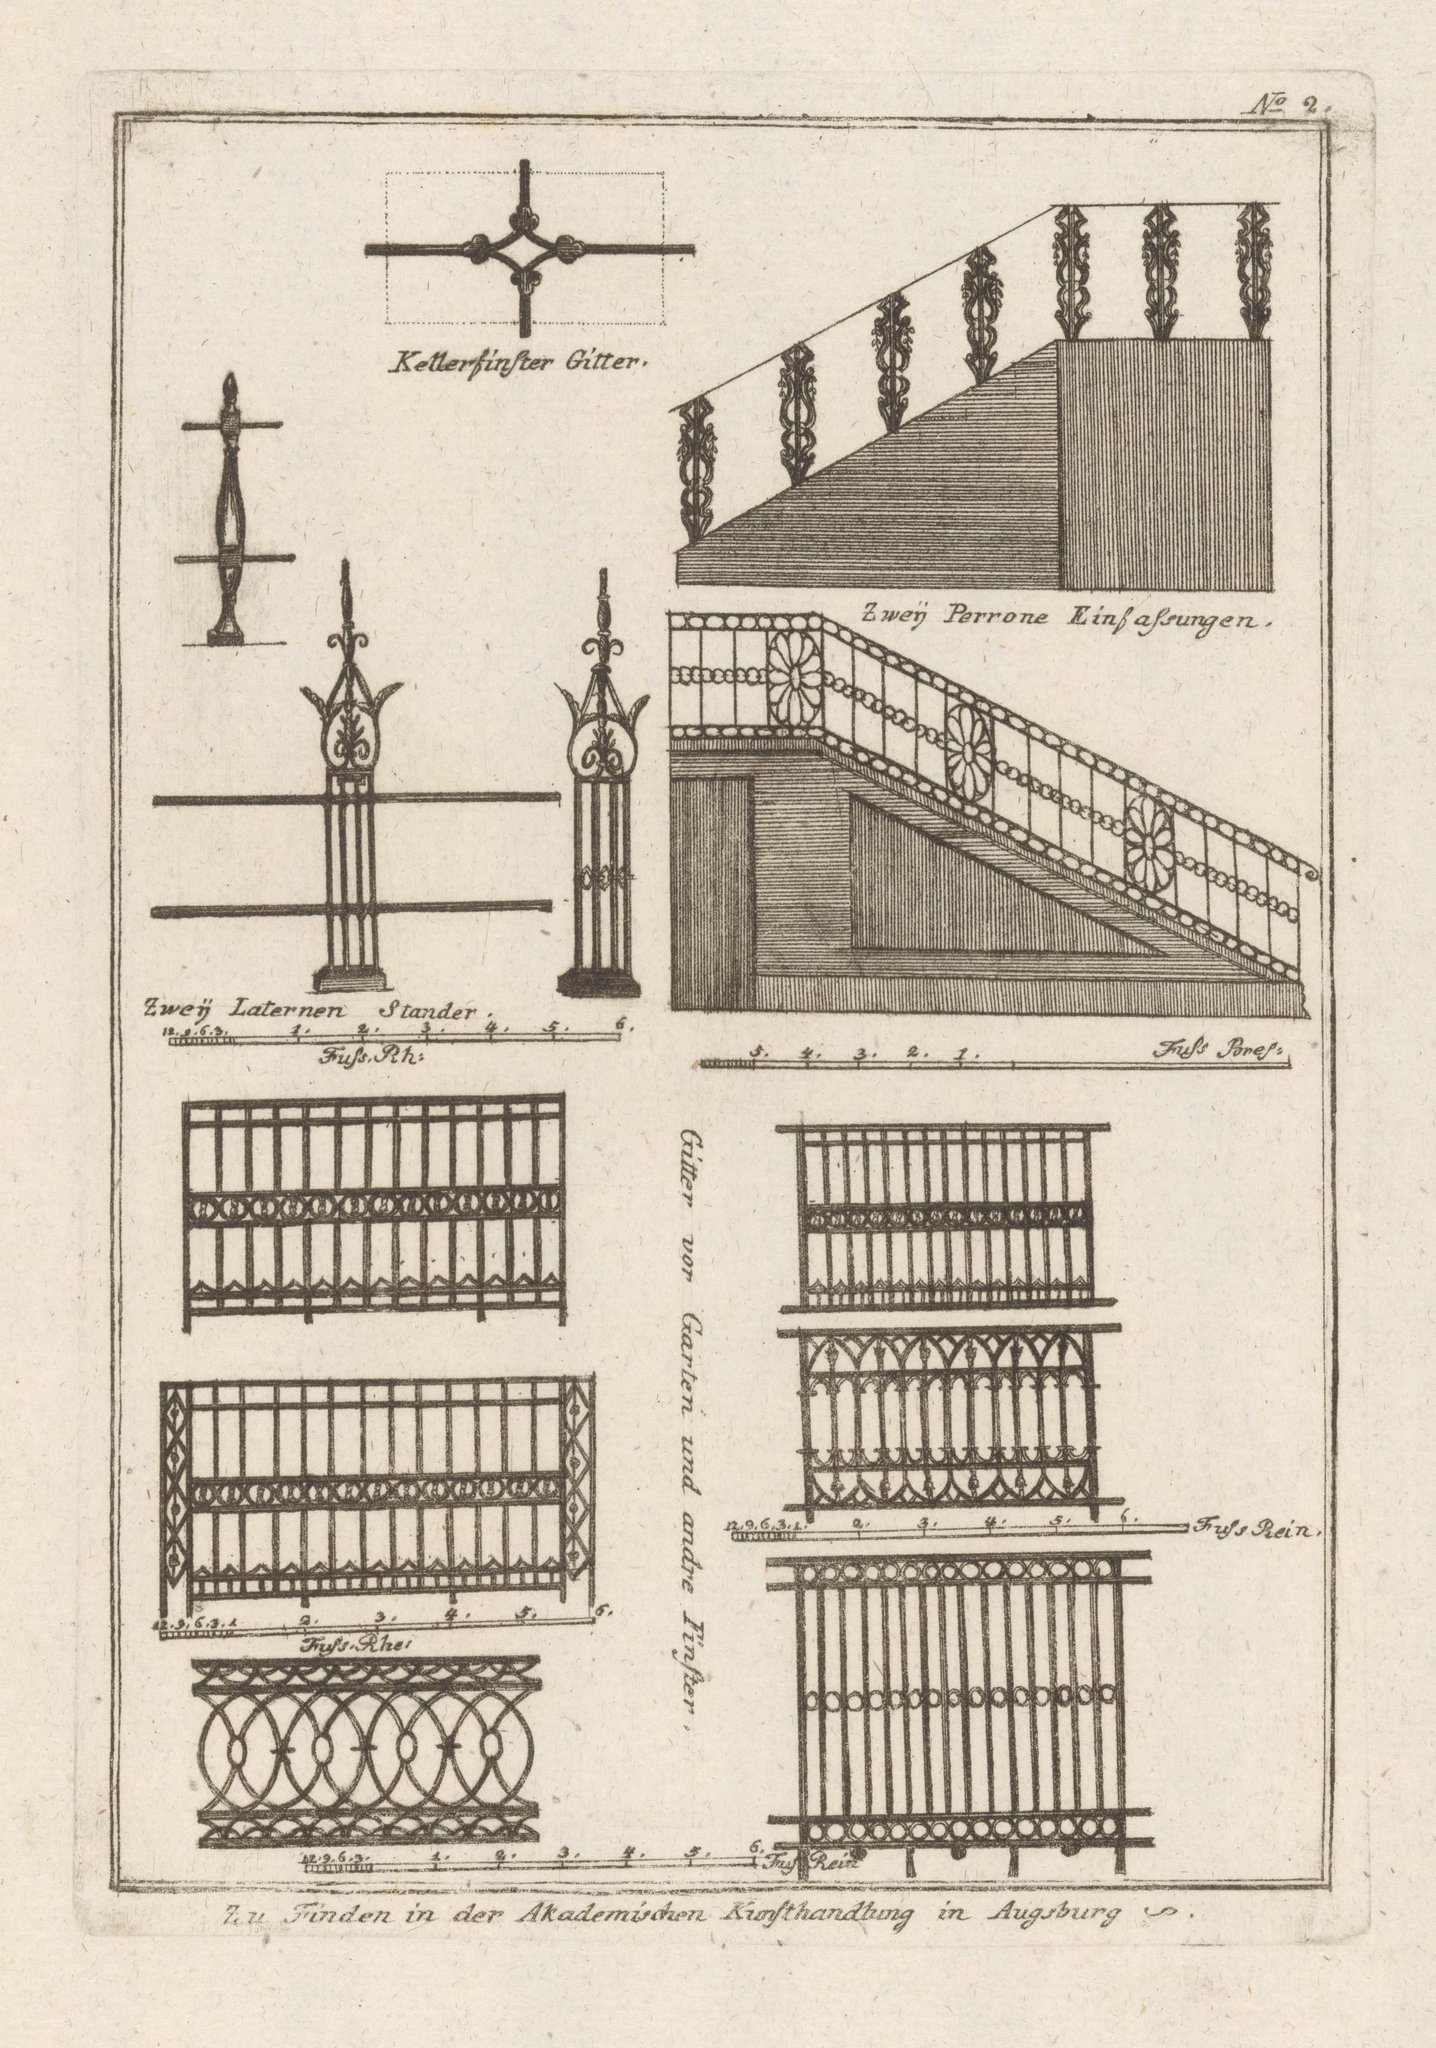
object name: print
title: Traphekken en hekwerken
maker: Anonymous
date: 1700-1799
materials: paper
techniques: etching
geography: germany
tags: welding (industrial process), fence, wall, paling, staircase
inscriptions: collector's mark: Lugt 2228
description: Ontwerpen voor smeedijzeren hekwerken en twee smeedijzeren traphekken. In de ondermarge de tekst zu finden in der Akademischen Kunsthandlung in Augsburg.